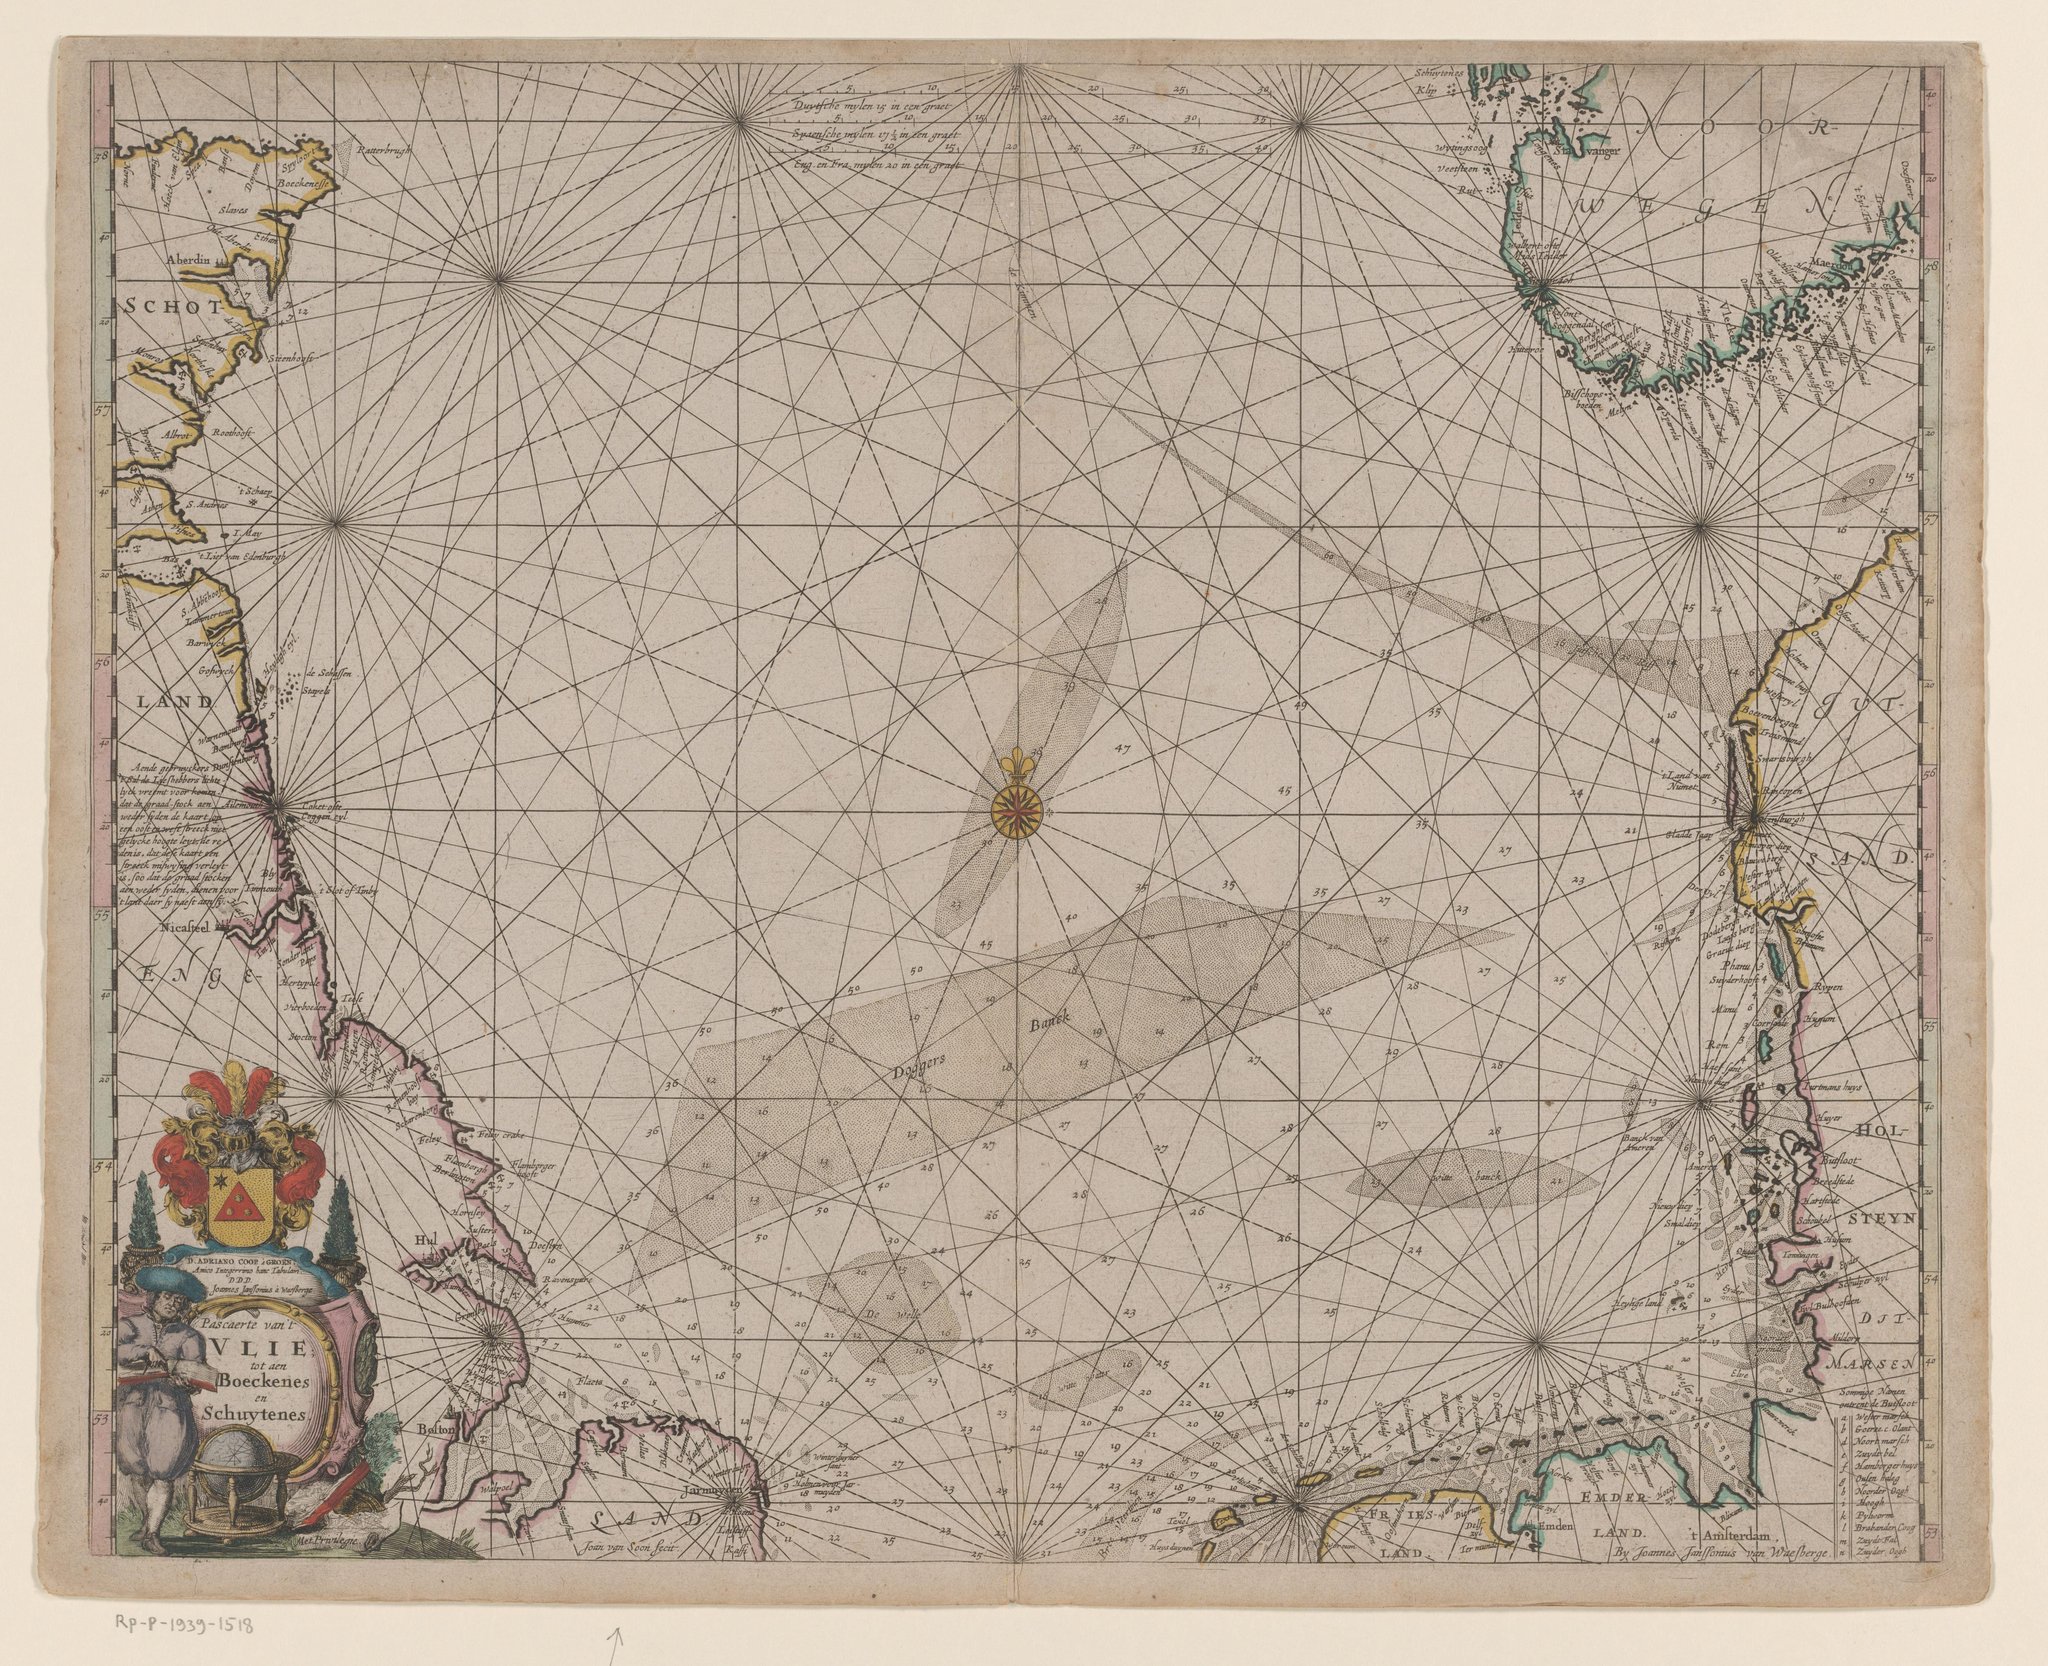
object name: print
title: Pascaerte van 't Vlie tot aen Boeckenes en Schuytenes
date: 1675-1680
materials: paper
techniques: engraving, hand coloring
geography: amsterdam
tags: marine charts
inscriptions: collector's mark: Lugt 2760, collector's mark: Lugt 2166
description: Paskaart van het Vlie. Linksonder de titelcartouche met bovenin het wapen van de familie Coop à Groen.